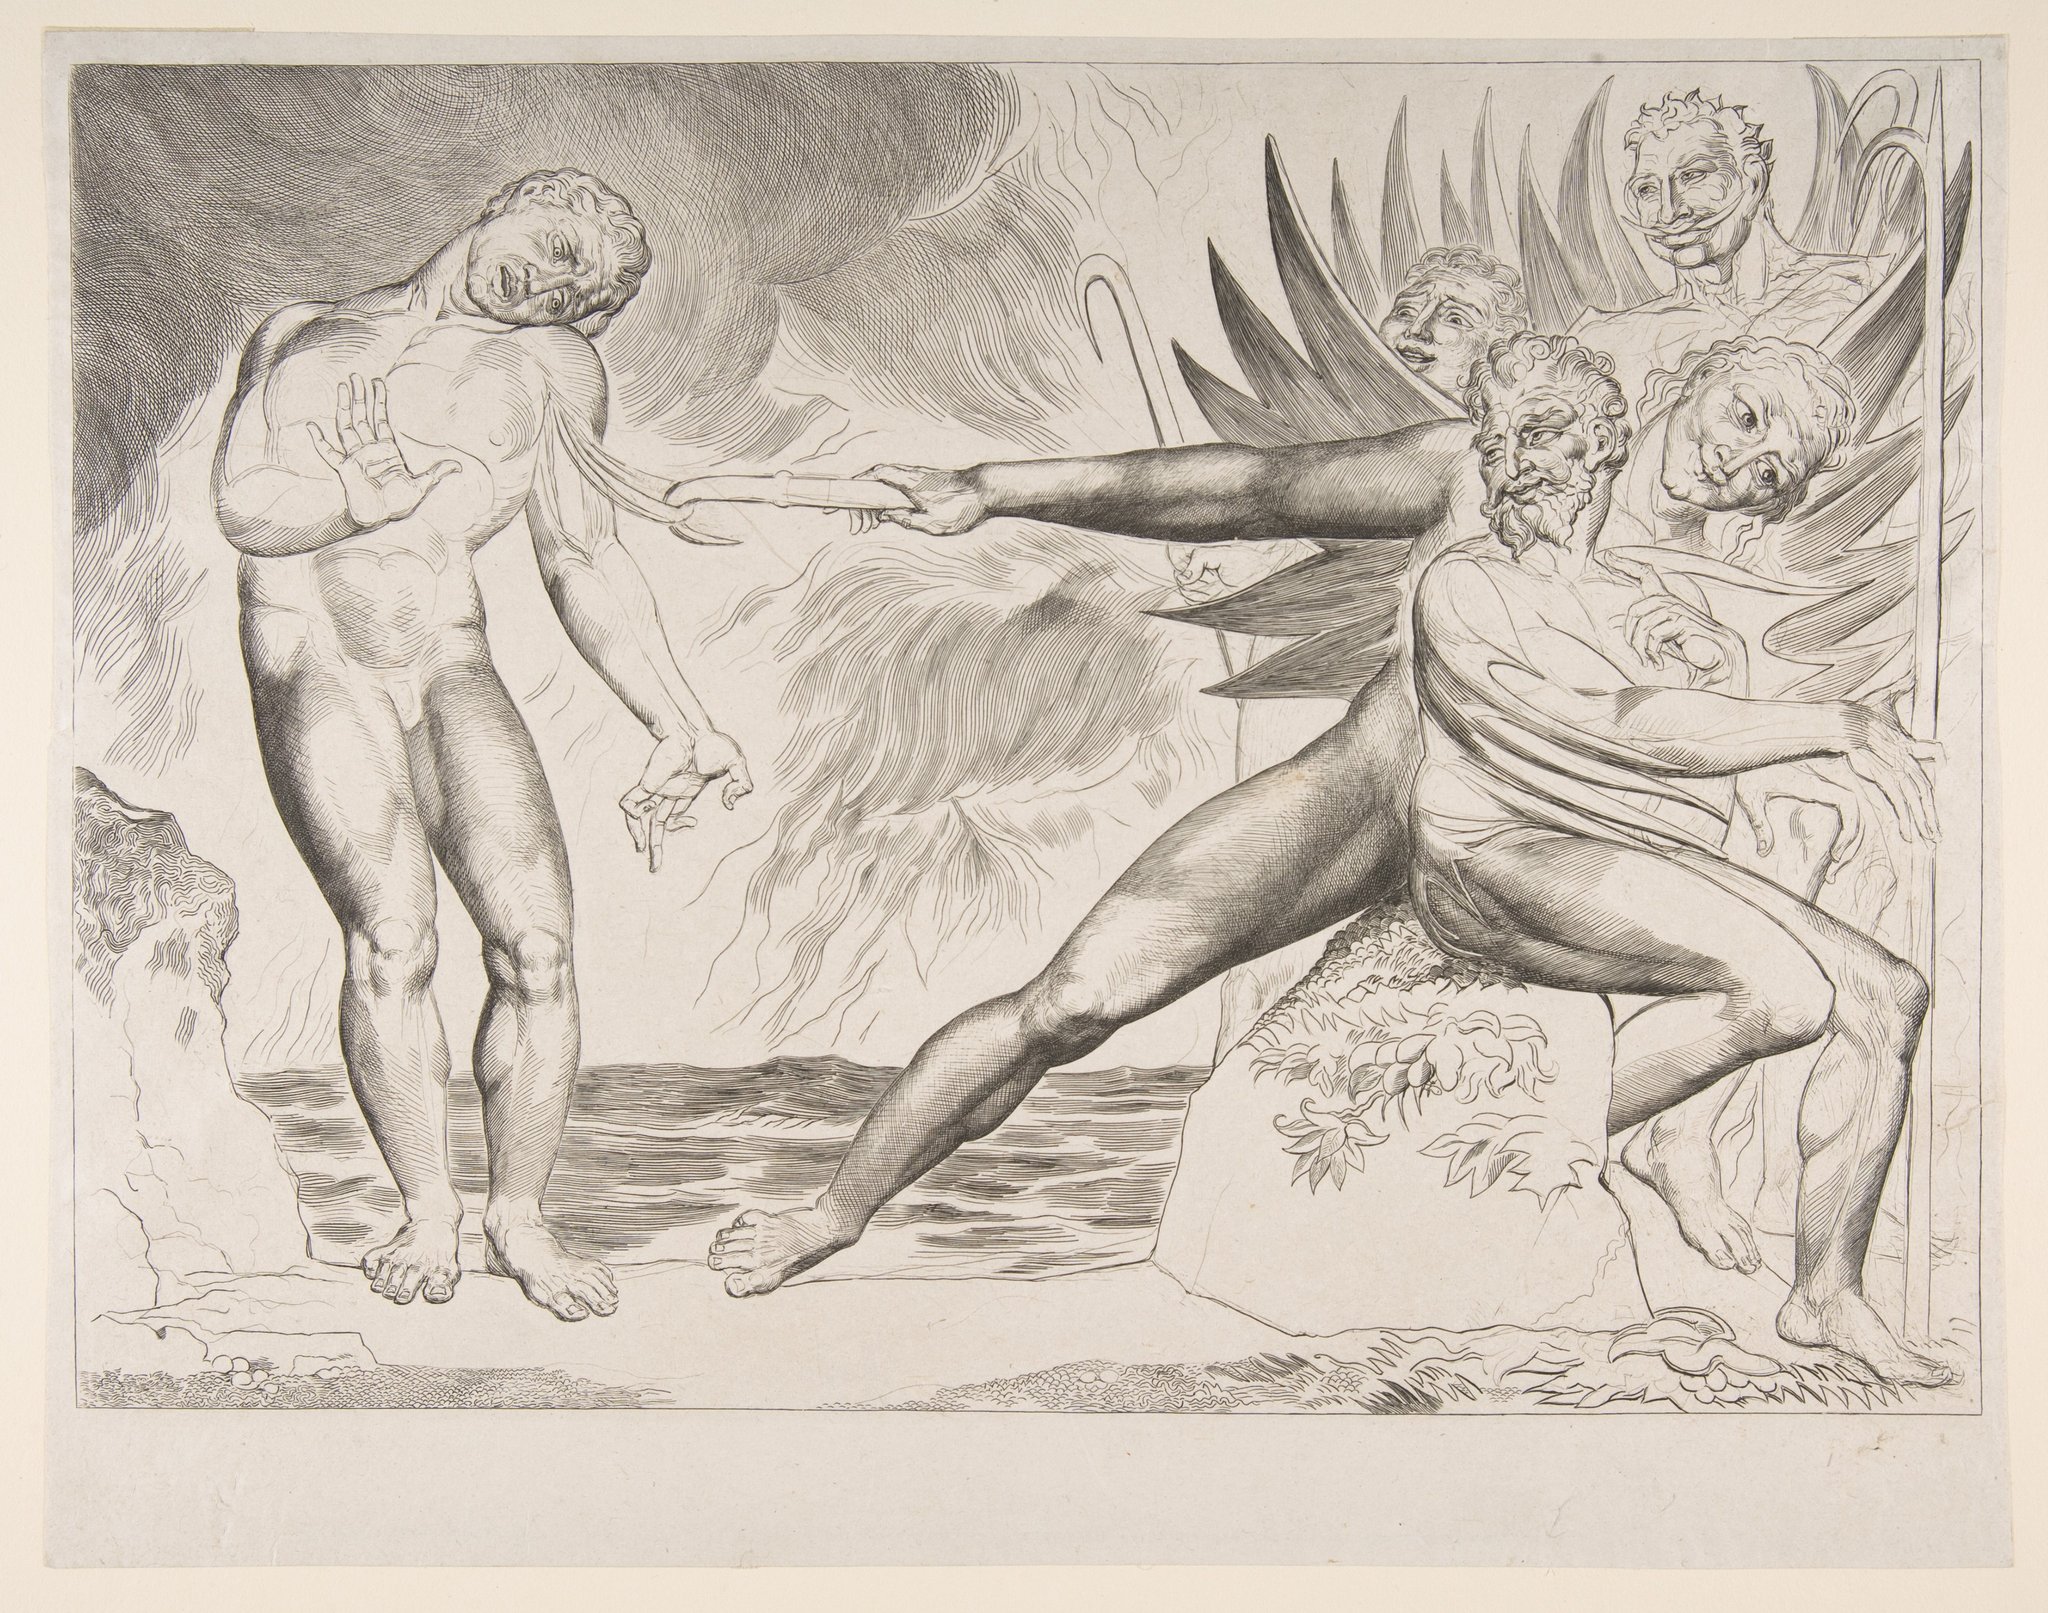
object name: print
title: The Circle of Corrupt Officials: The Devils Tormenting Ciampolo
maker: william blake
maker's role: artist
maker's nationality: british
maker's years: 1757-1827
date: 1825-1827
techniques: engraving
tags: weapons,male nudes,devil